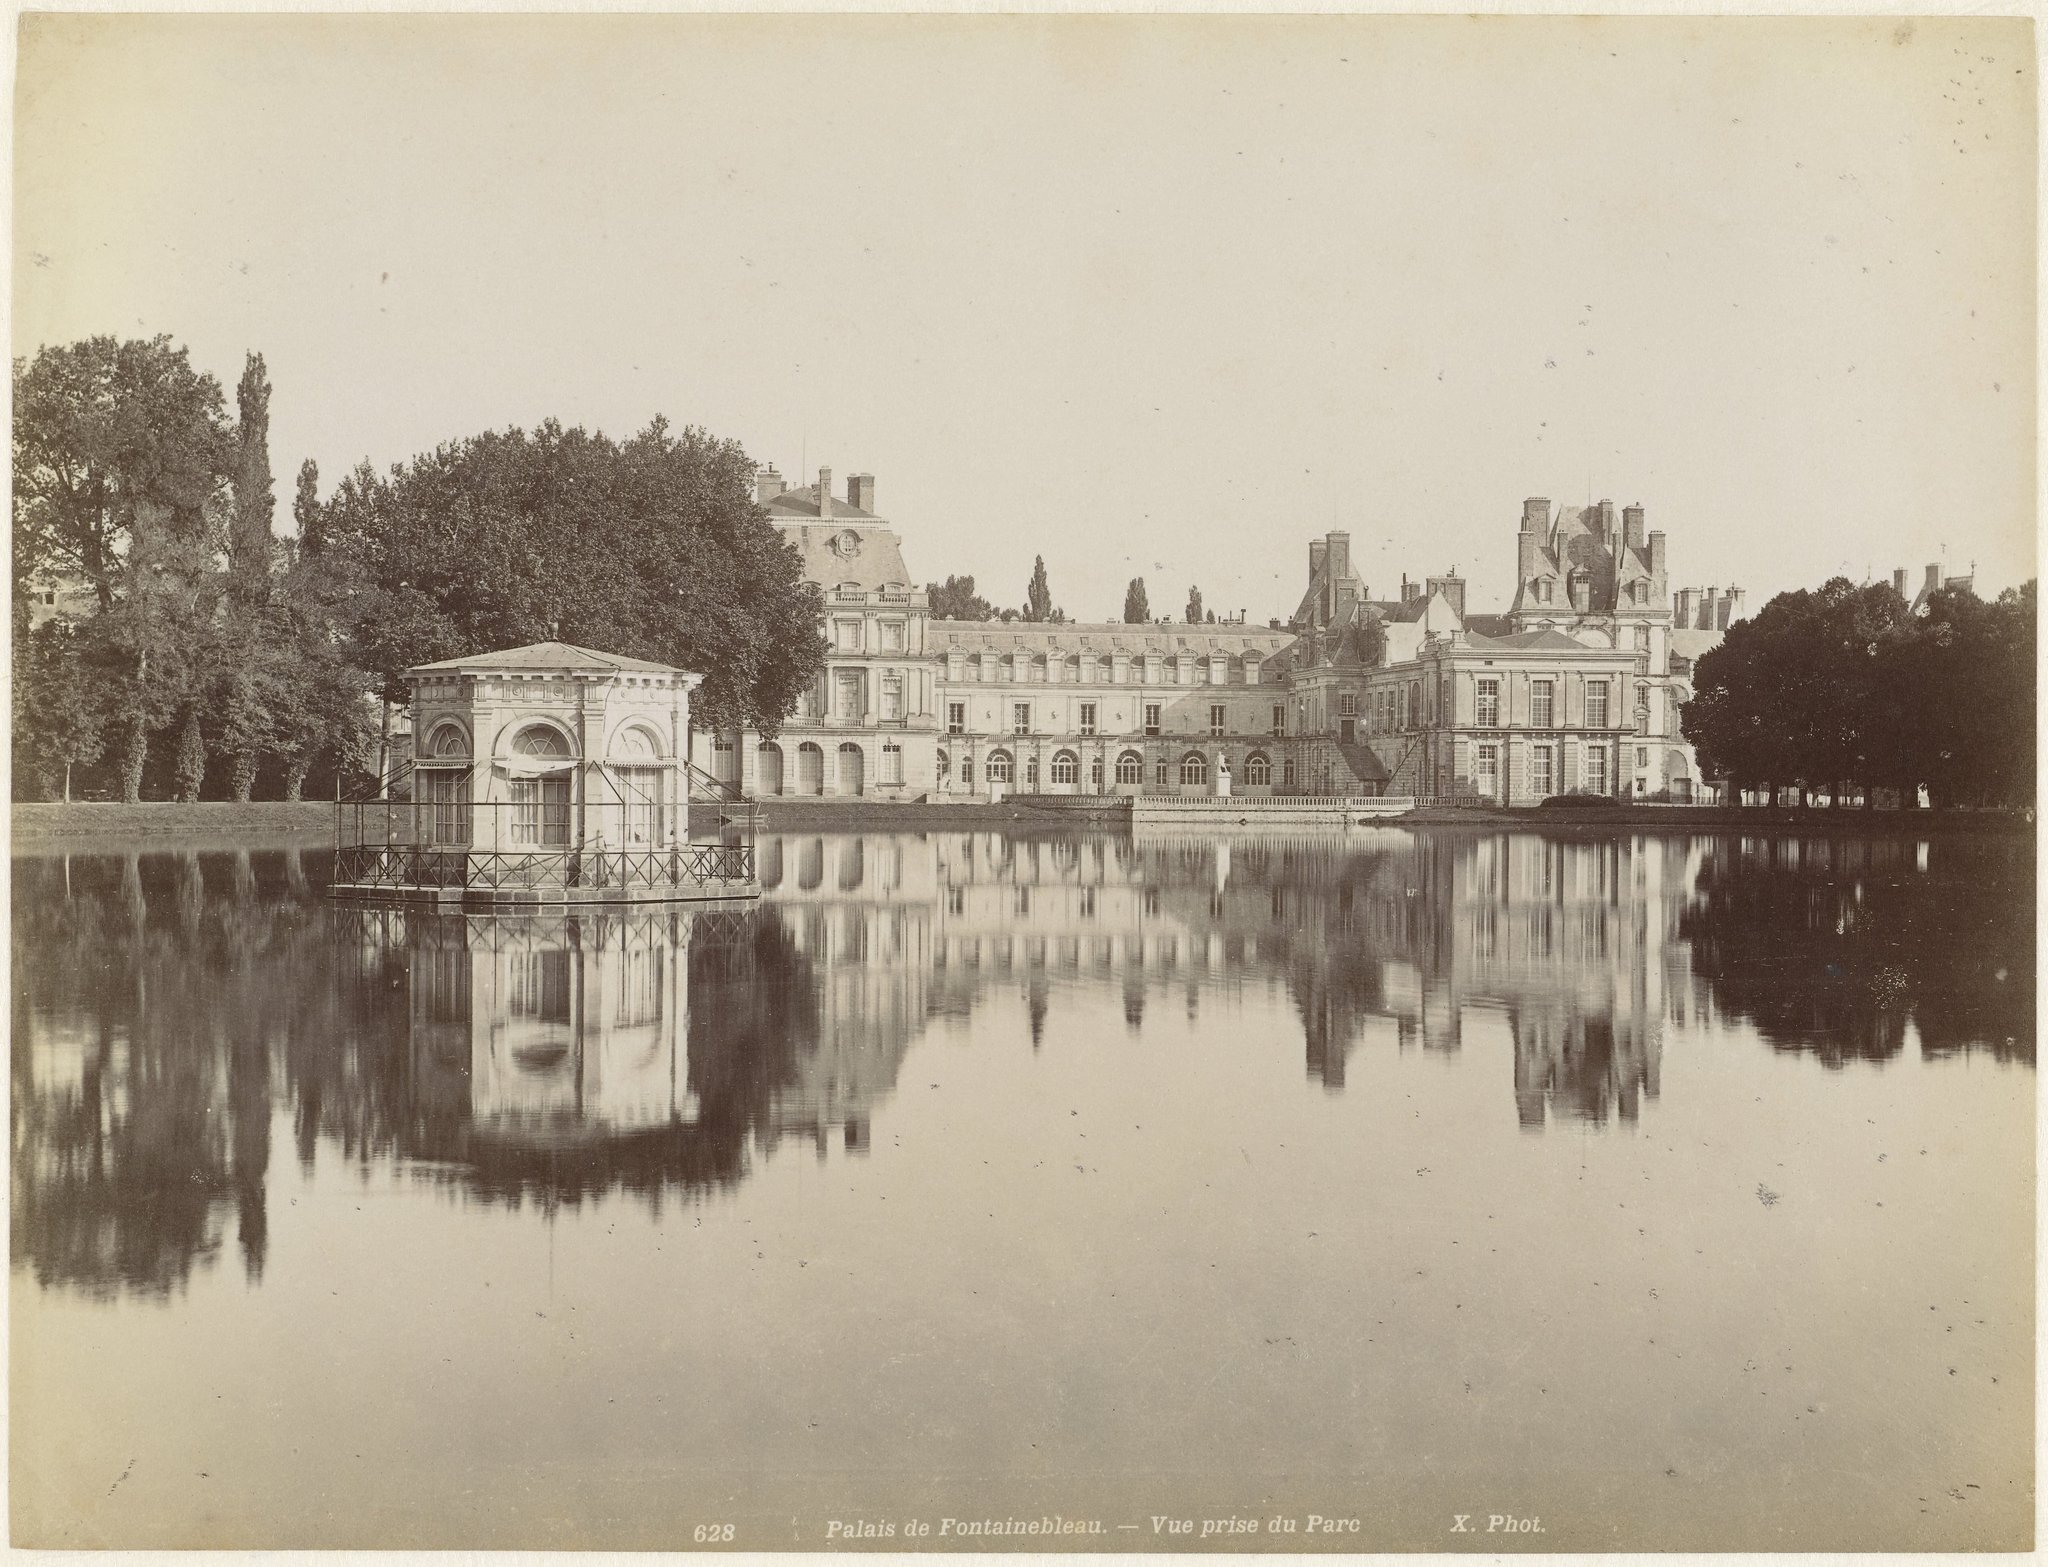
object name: photograph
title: Palais de Fontainebleau - vue prise du Parc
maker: jules hautecoeur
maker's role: publisher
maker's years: 1849-1935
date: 1887-1900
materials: paper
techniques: albumen print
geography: paris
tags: palace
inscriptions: number: ‘1075’, number: ‘628’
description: Tussen 1887 en ca. 1900 werkten Neurdein frères onder andere onder de naam 'X phot.'.